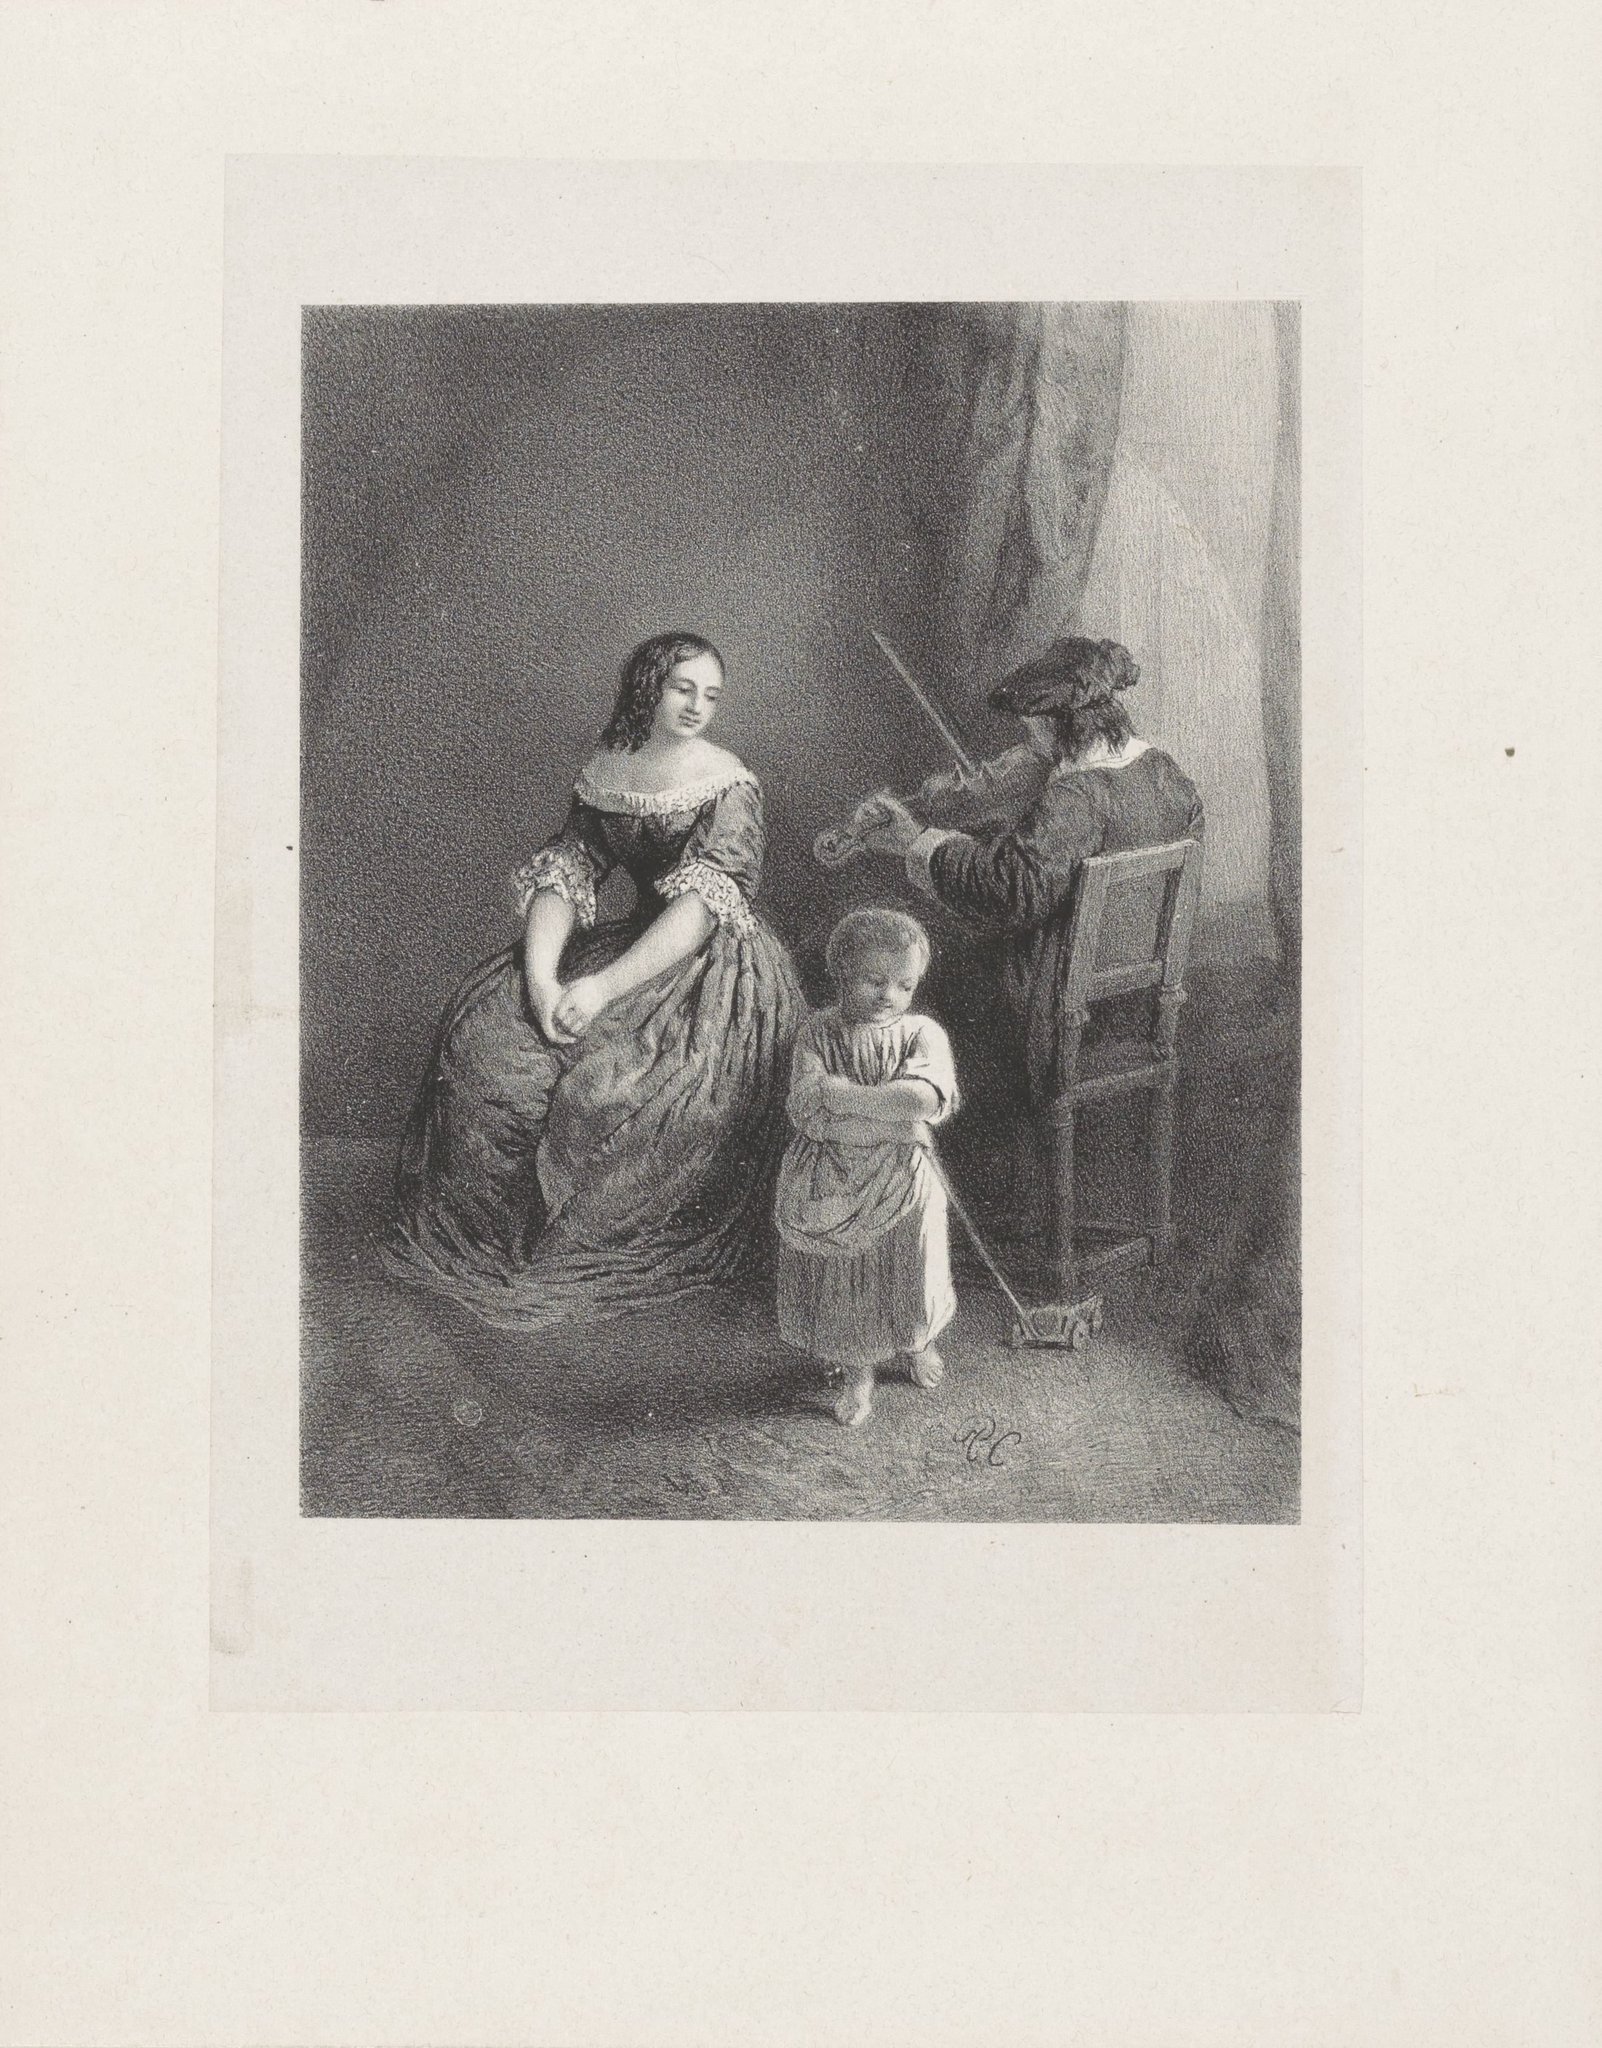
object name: print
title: Vioolspelende man met vrouw en kind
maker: reinier craeyvanger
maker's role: draughtsman, print maker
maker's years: 1812-1880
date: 1858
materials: paper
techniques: lithograph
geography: netherlands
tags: family group, especially parents with their child(ren), violin, fiddle, (playing with) wheeled vehicles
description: De man en vrouw zitten op een stoel. De man, op de rug gezien, speelt viool. Voor hen staat een kind met de armen gekruist en in de hand een touw met daaraan een speelgoedauto. Deze prent werd gepubliceerd in De Kunstkronijk.